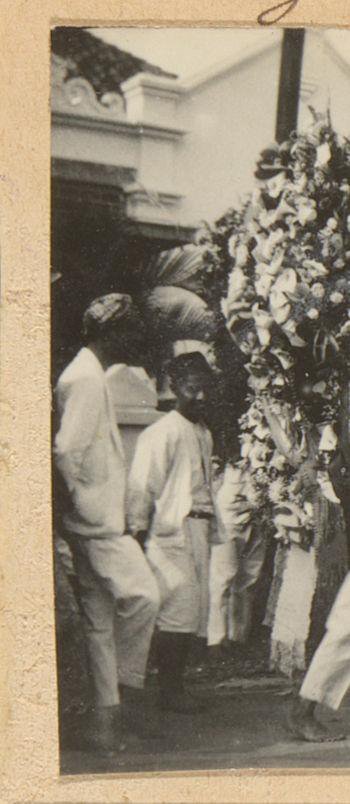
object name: photograph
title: Rouwstoet, vermoedelijk in Jogjakarta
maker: Anonymous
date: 1916-1917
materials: photographic support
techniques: gelatin silver print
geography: jogjakarta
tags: cortege, funeral procession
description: Onderdeel van Familiealbum met foto's van een familie in de voormalige kolonie Nederlands-Indië en van een suikerfabriek in Purworejo.